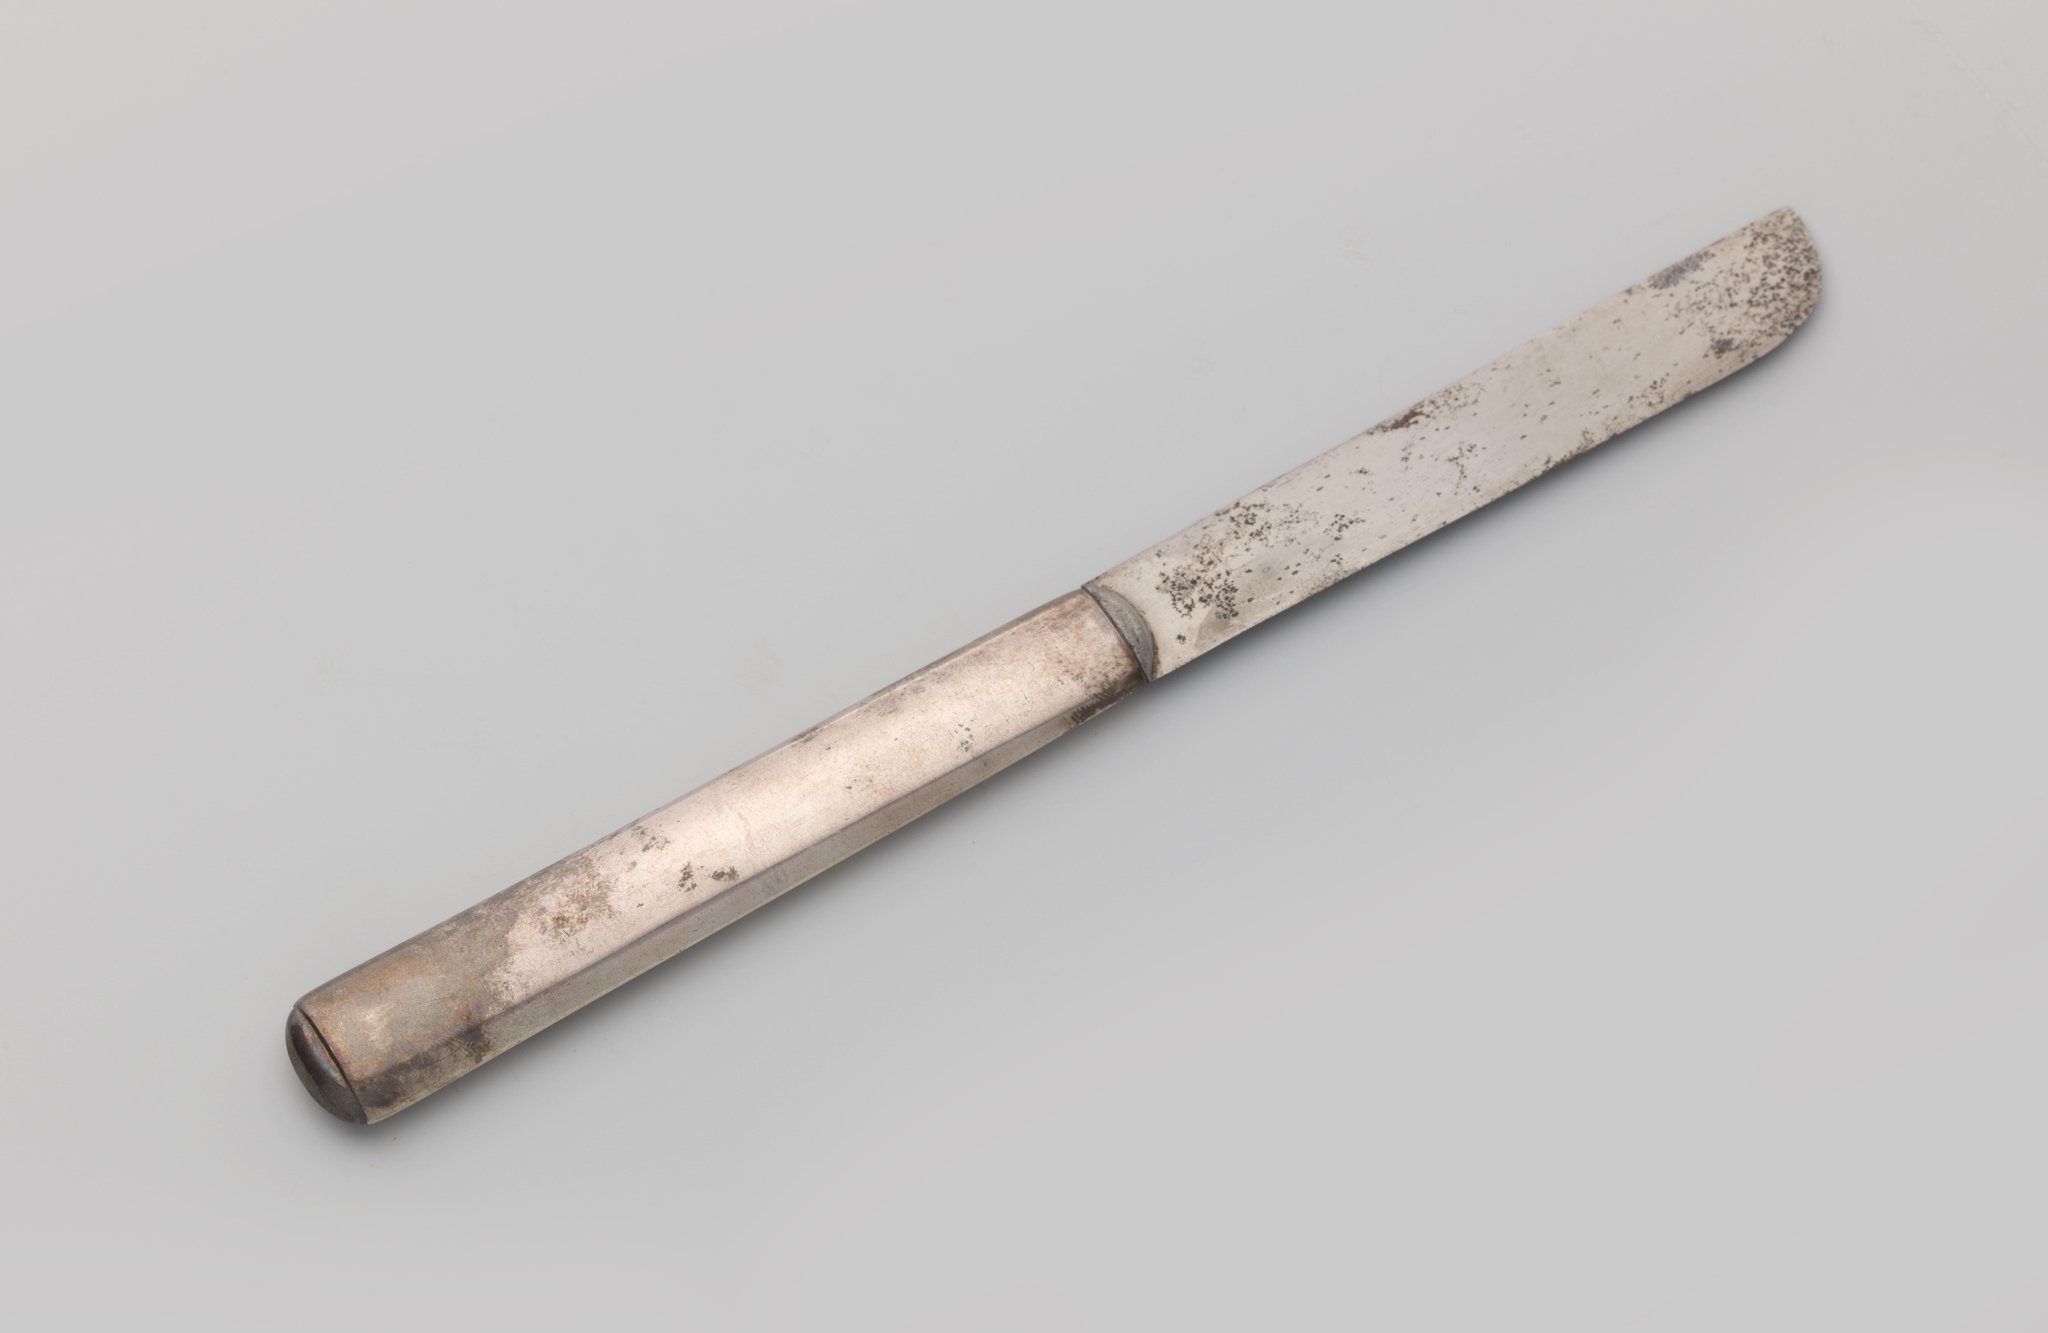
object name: knife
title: Mes met zich naar het uitende verbredend heft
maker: josef hoffmann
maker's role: designer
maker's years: 1870-1956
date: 1907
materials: alloy, steel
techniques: silvering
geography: vienna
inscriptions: : ‘WW dooreen’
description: Mes met stalen lemmet. Het heft is plat en verbreedt naar het uiteinde toe.